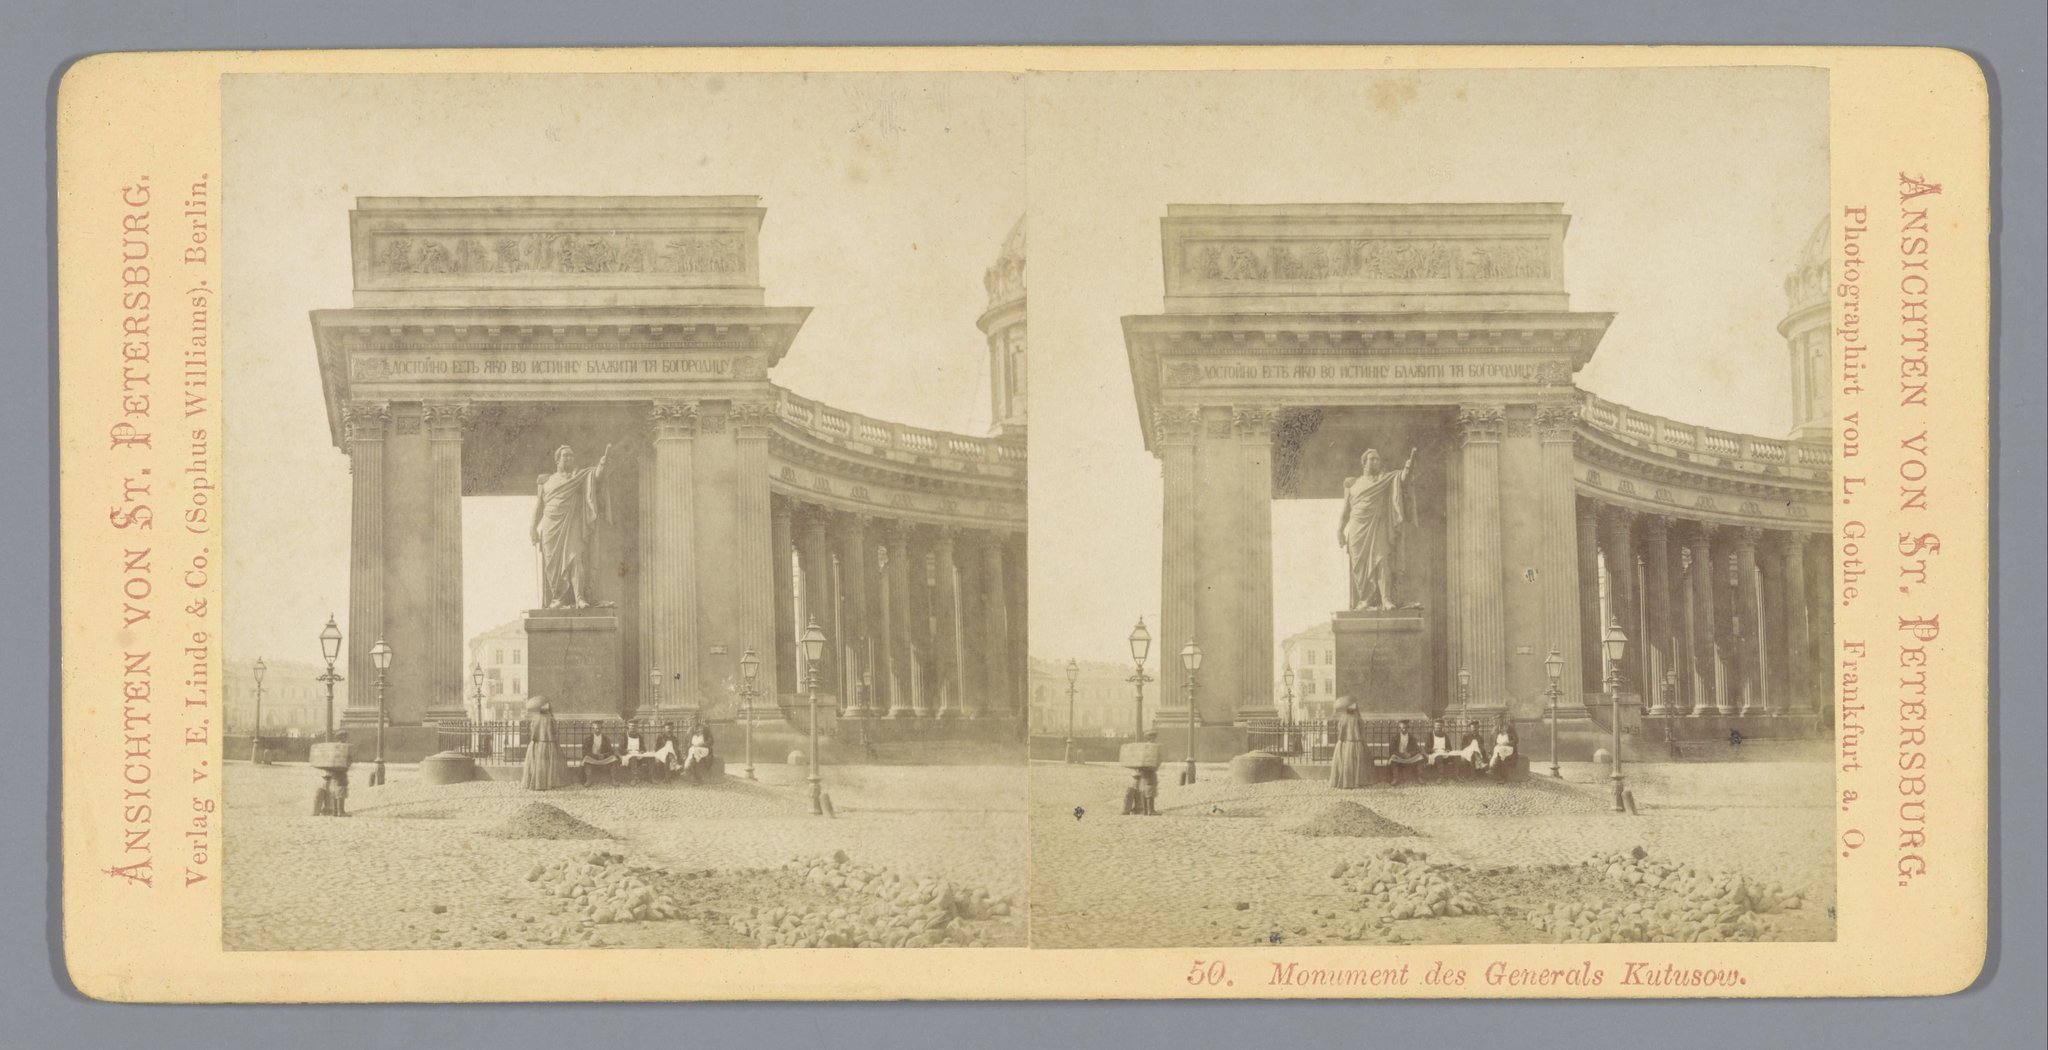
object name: stereograph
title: Monument des Generals Kutusow.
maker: louis gothe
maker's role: fotograaf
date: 1850-1880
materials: cardboard, photographic support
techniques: albumen print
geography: berlin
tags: monument, statue (+ city(-scape) with figures, staffage)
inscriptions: number: ‘50.’, inscription: ‘Ansichten von St. Petersburg.’